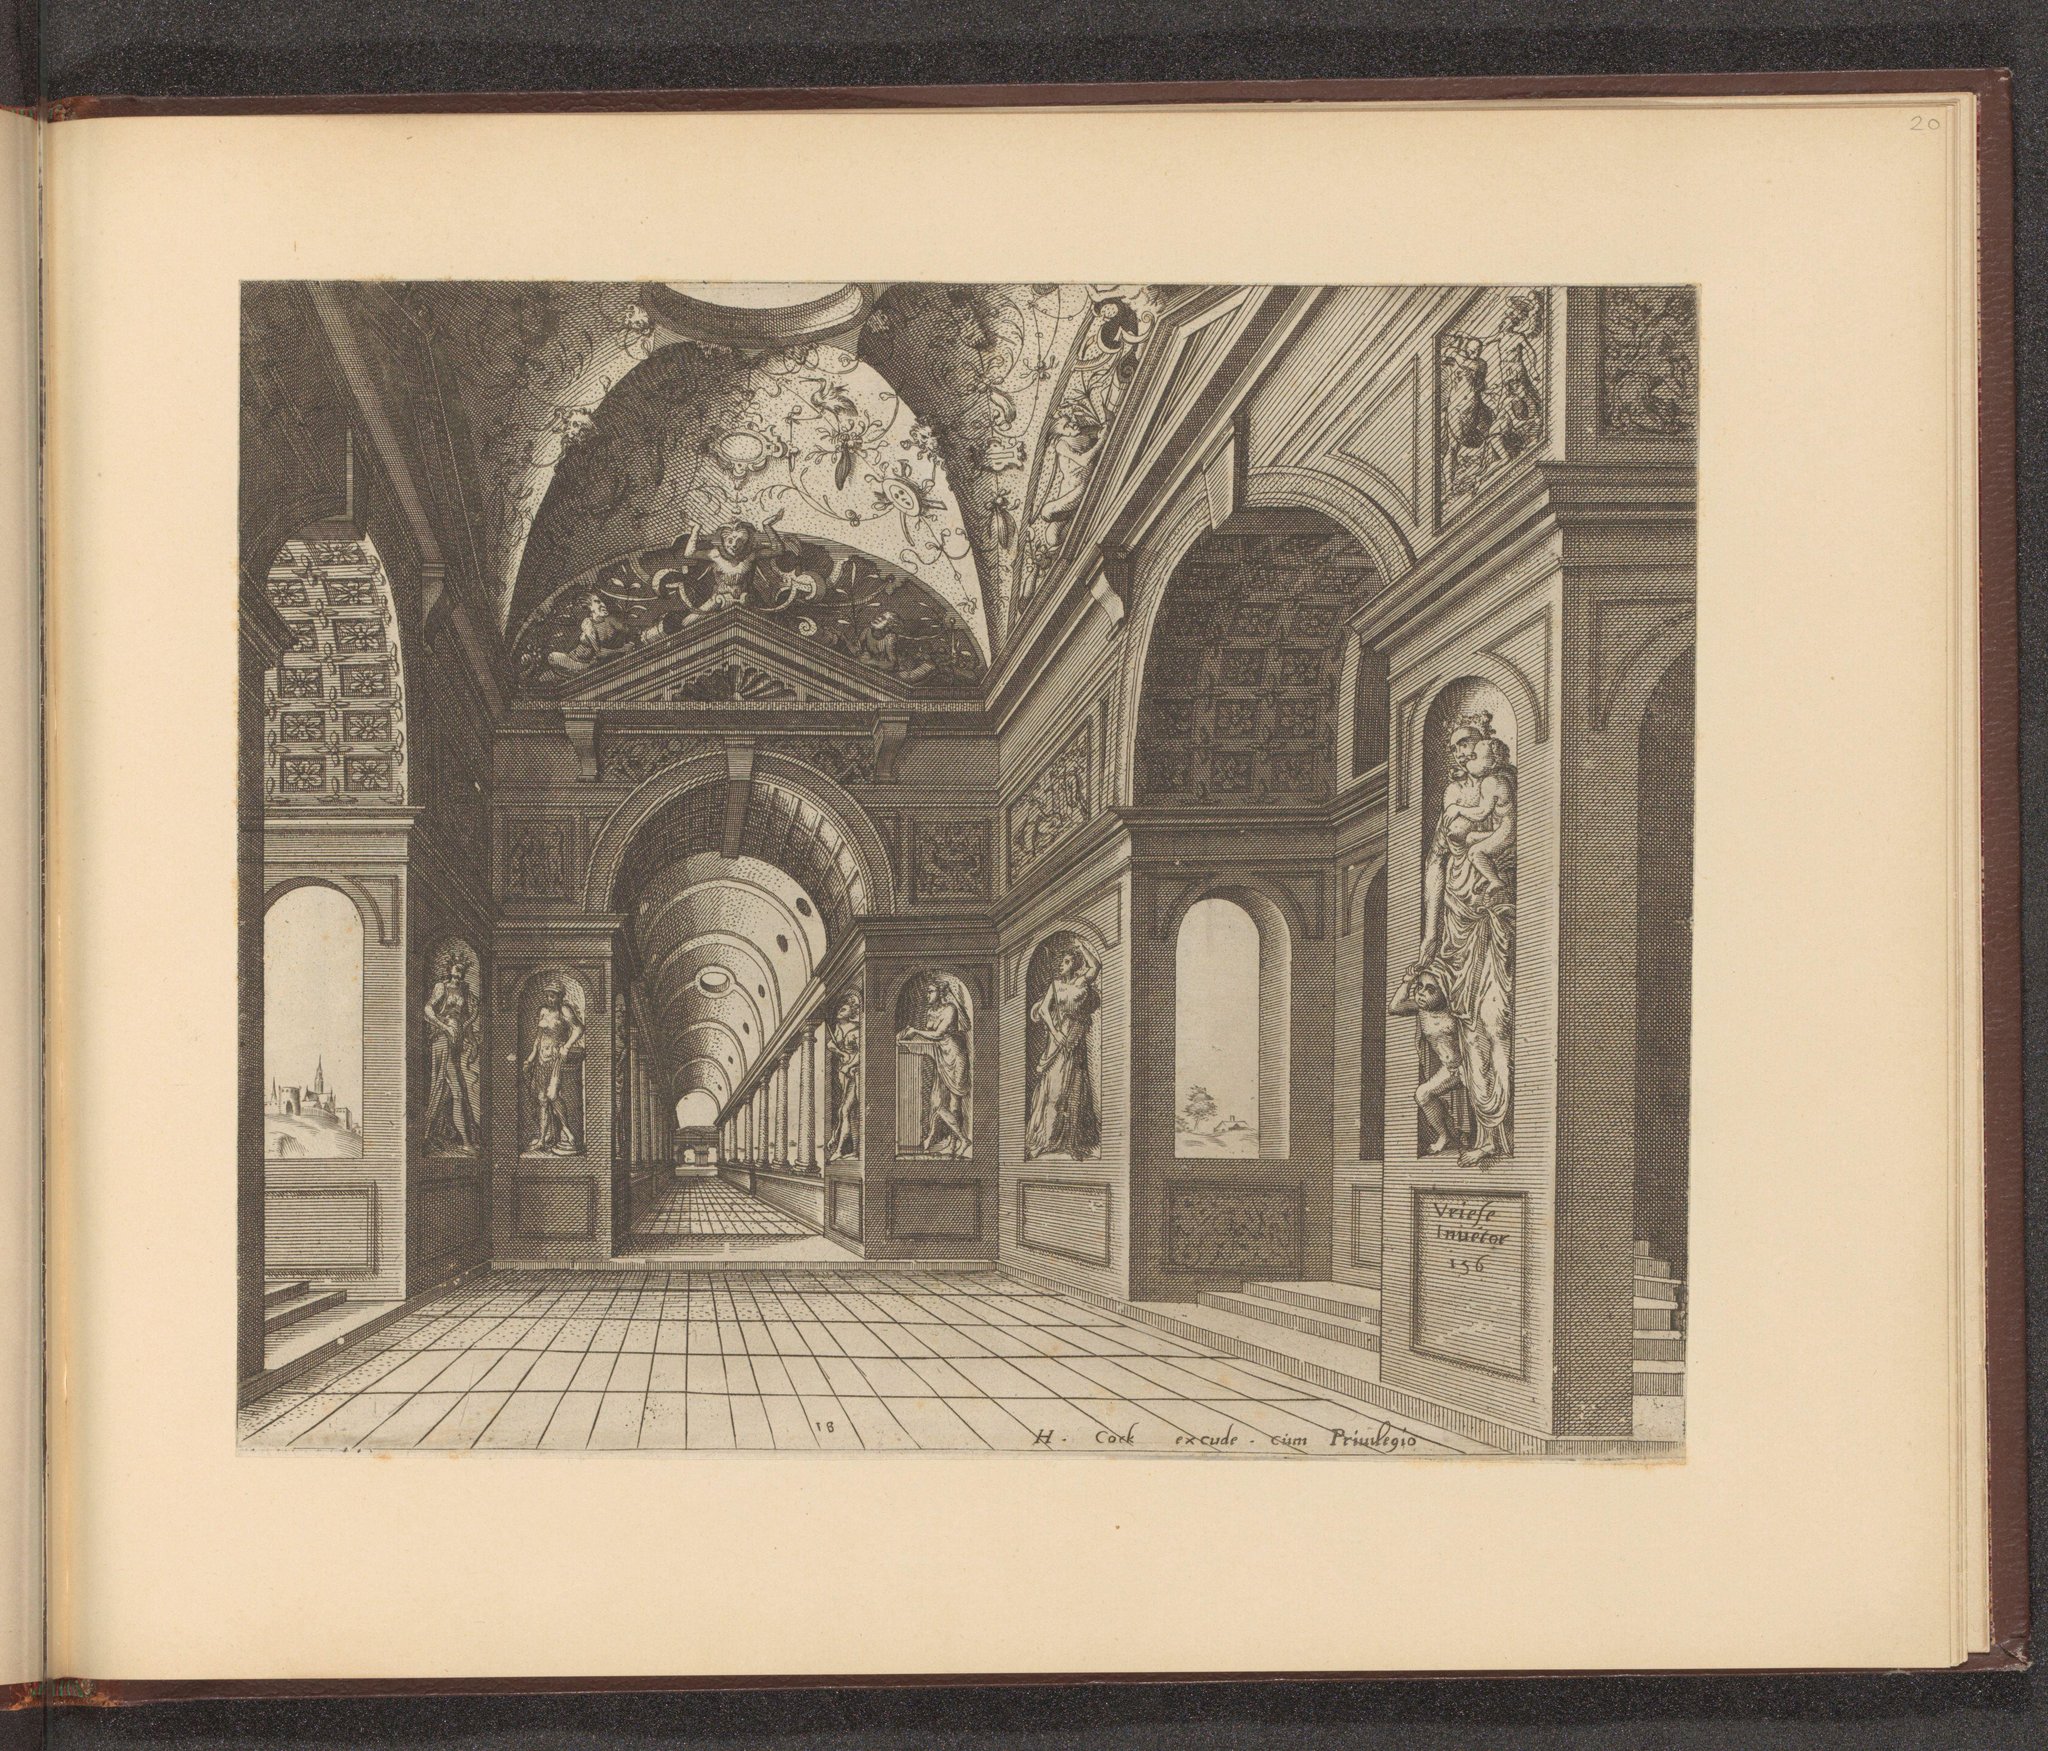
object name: album leaf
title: Hal met een kruisgewelf versierd met grotesken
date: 1563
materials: paper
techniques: etching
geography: antwerp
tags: ornament ~ grotesque, monument, statue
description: Hal met een kruisgewelf versierd met grotesken. In nissen staan standbeelden. Prent maakt deel uit van een album.